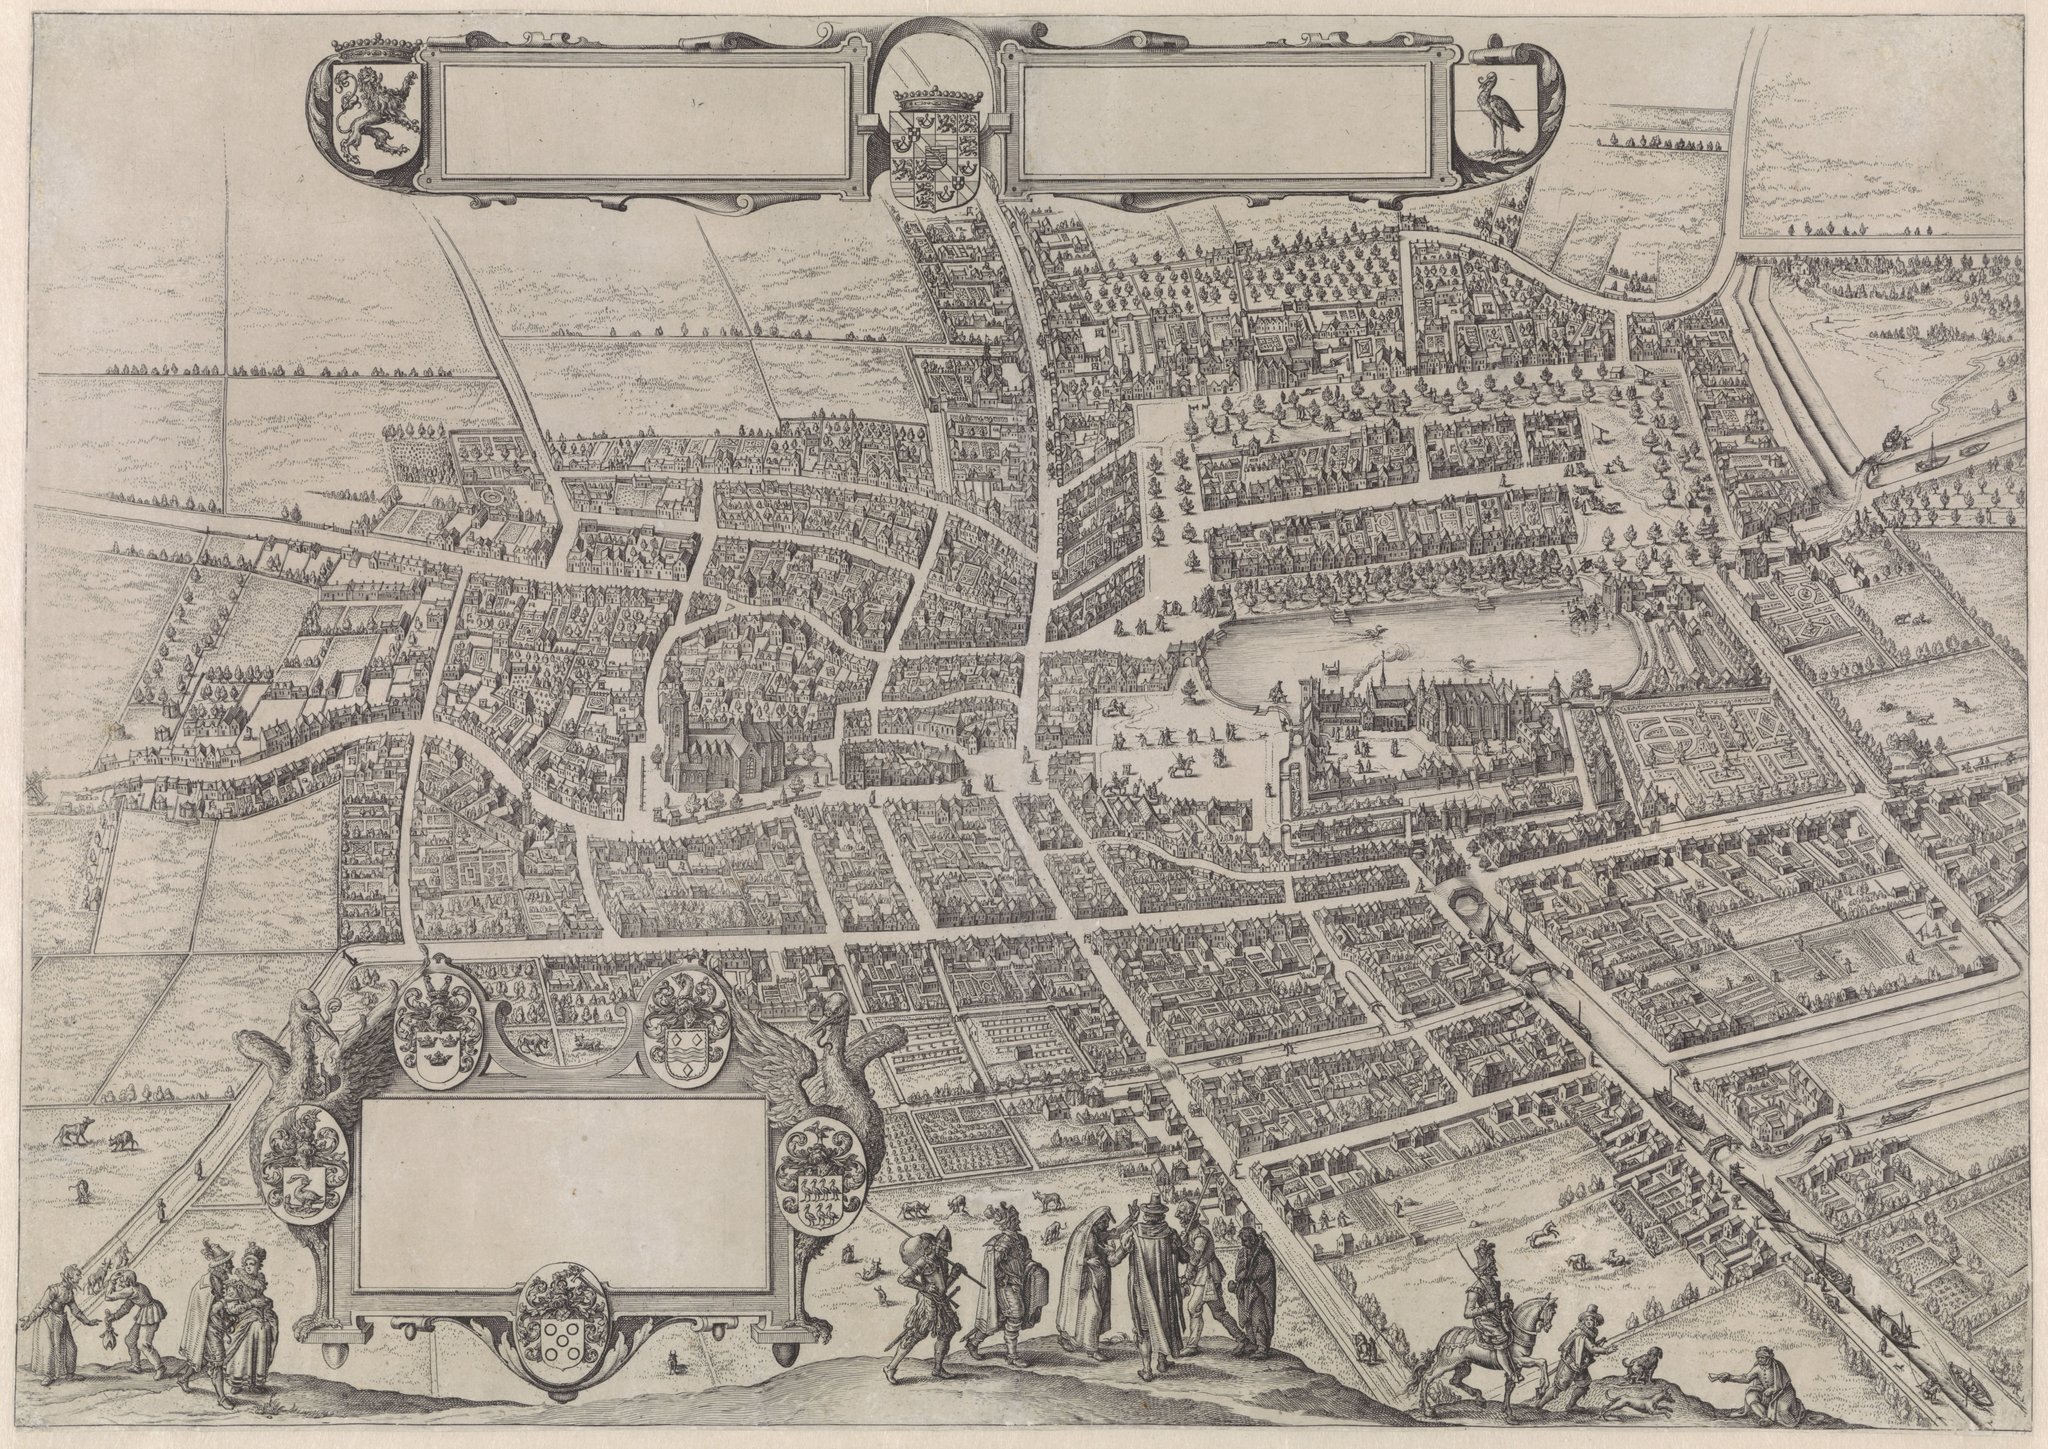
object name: print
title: Plattegrond van Den Haag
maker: jacques de gheyn (ii)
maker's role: painter, print maker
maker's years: 1565-1629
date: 1598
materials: paper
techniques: engraving, etching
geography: the hague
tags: the hague, maurice (prince of orange), maps, atlases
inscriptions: collector's mark: Lugt 2760, collector's mark: Lugt 2228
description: Plattegrond van Den Haag met daarop ingetekend de grachtengordel naar ontwerp van prins Maurits. Boven en onder het plattegrond lege kaders met de wapenschilden van Holland en Den Haag.